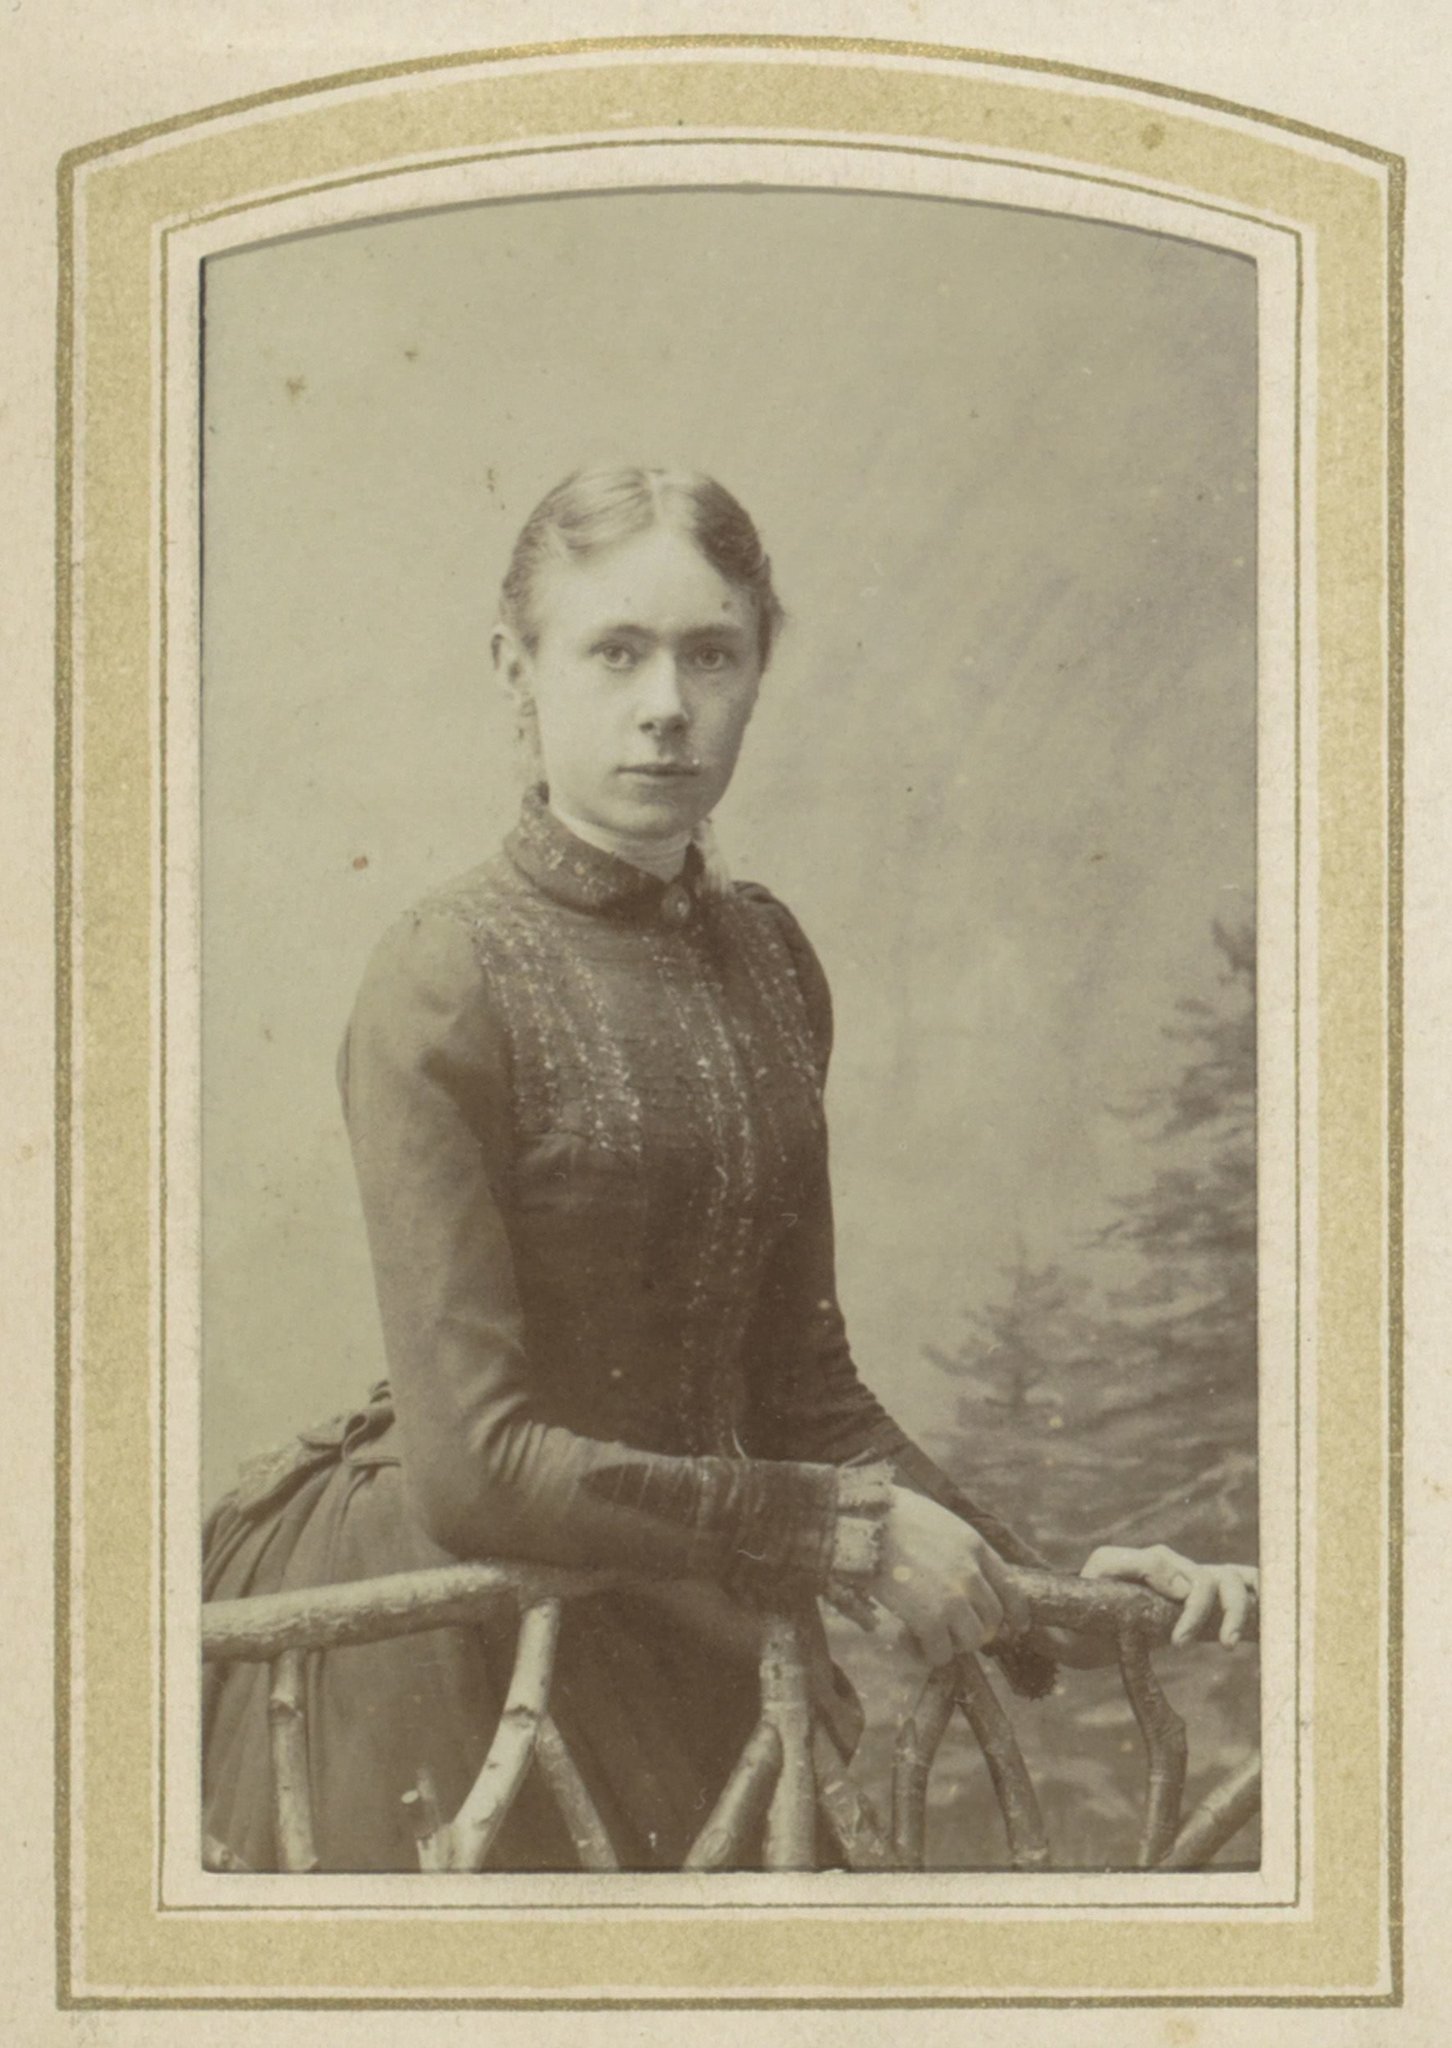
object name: carte de visite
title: Portret van een vrouw met een jurk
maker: johannes leonardus van der heijden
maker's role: fotograaf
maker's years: 1856-1937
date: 1875-1900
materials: cardboard, paper, photographic support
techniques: albumen print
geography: amsterdam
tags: studio requisites ~ photographer, historical persons, styles of hairdress - aa - ~ women, neck-gear ~ clothing, dress, gown, amsterdam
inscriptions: address: ‘Singel 435 Hoek Heiligenweg’, address: ‘Amsterdam Singel 435’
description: Onderdeel van Fotoalbum van een Nederlandse familie met 168 cartes-de-visite en kabinetfoto's.